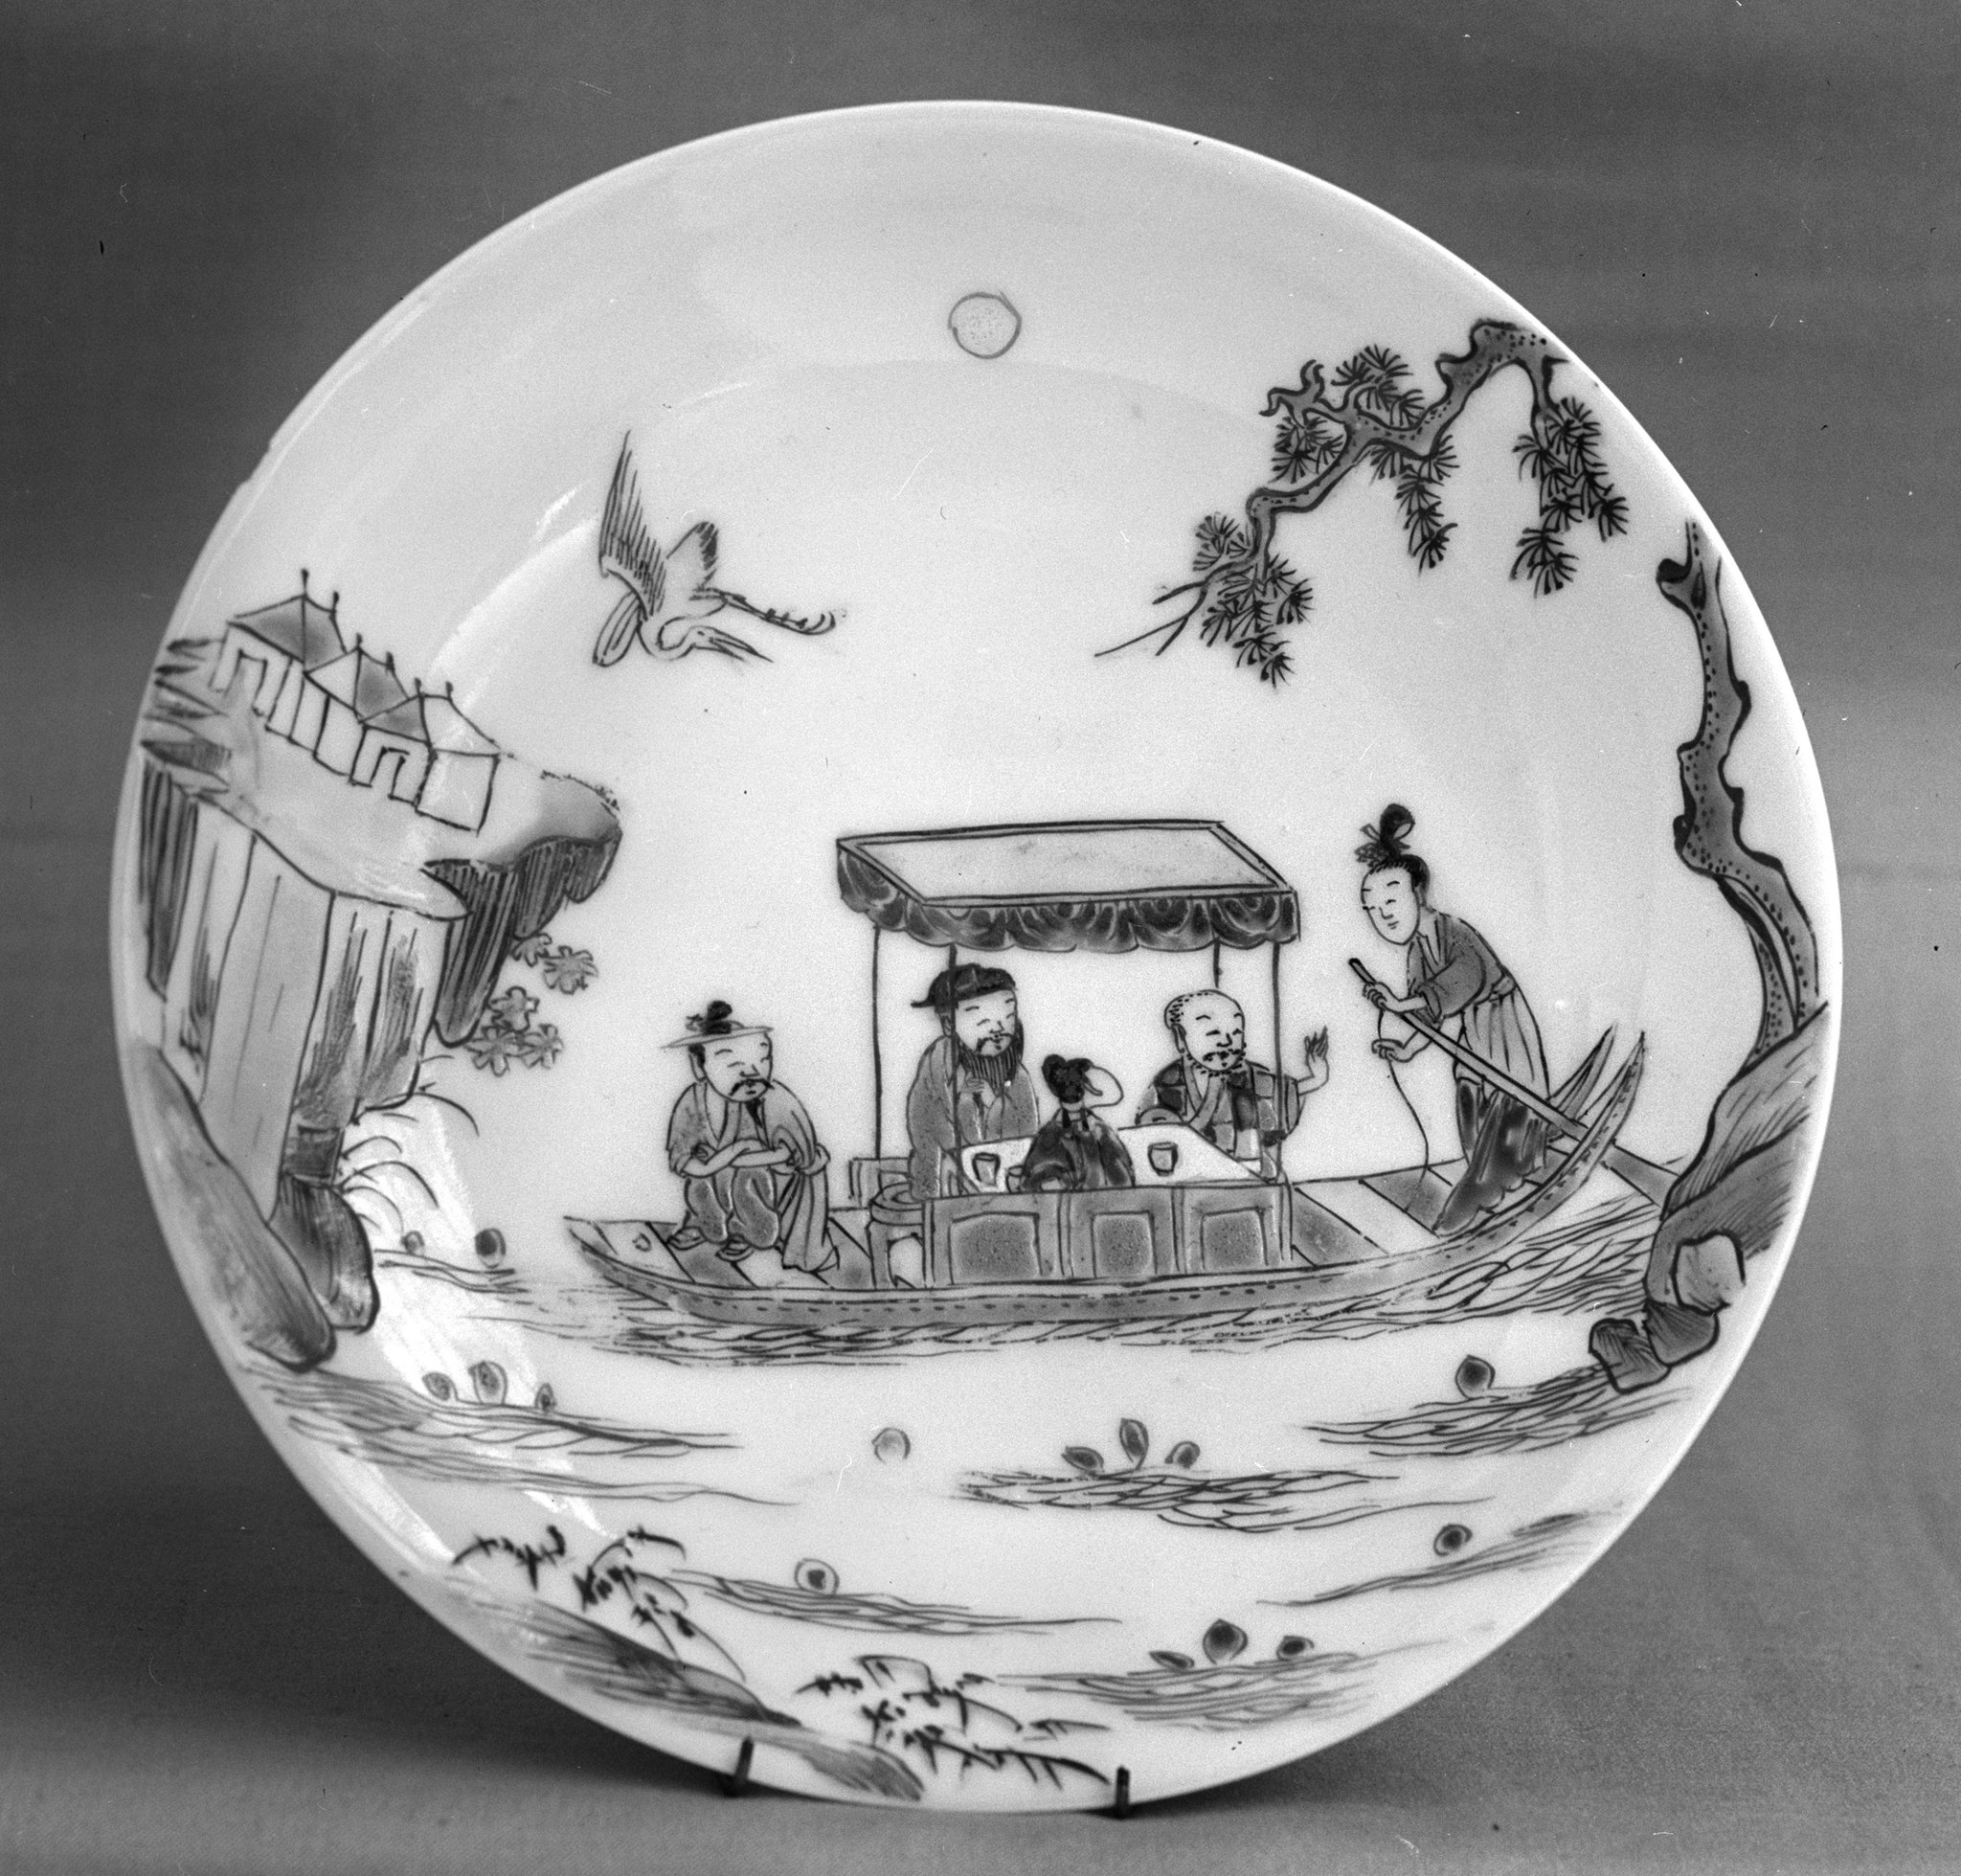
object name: saucer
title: Saucer with figures in boat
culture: chinese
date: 1767-1800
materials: enamel, porcelain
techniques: overglaze, painting, polychrome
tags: cranes,men,boats